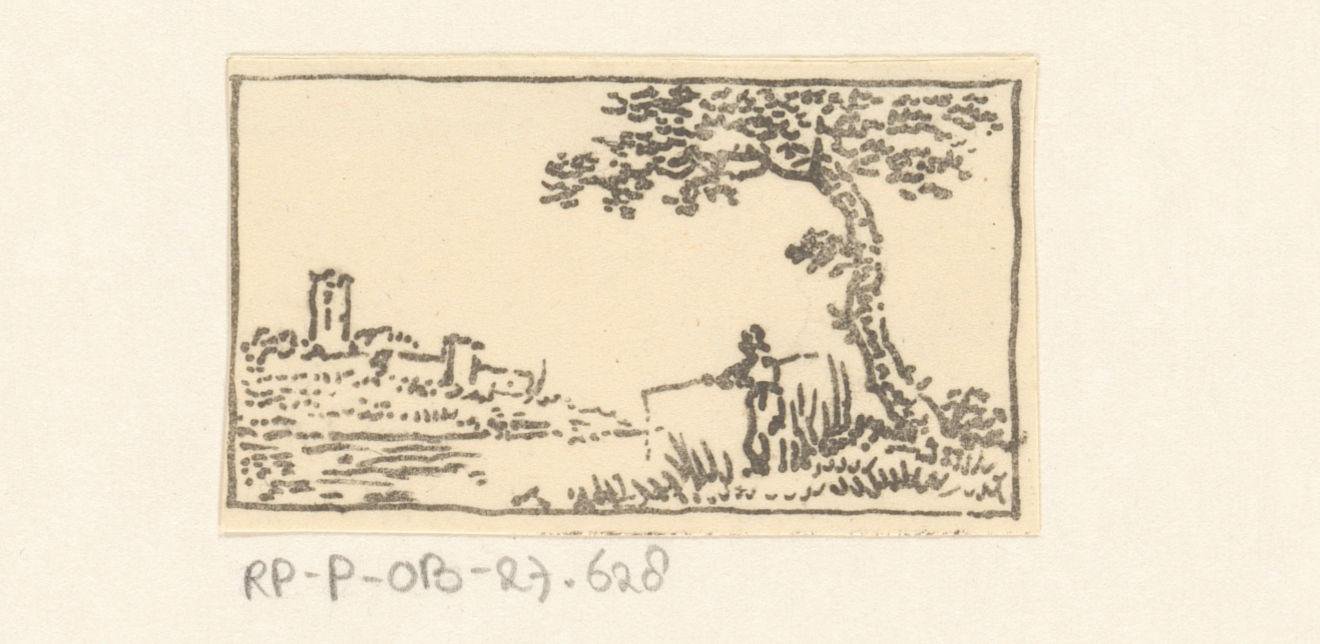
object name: print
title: Landschap met visser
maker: pieter bartholomeusz. barbiers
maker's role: draughtsman, print maker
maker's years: 1772-1837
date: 1809-1837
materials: paper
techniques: lithograph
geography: haarlem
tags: landscapes, fisherman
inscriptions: collector's mark: Lugt 228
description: De visser staat onder een boom. In de verte een dorp.